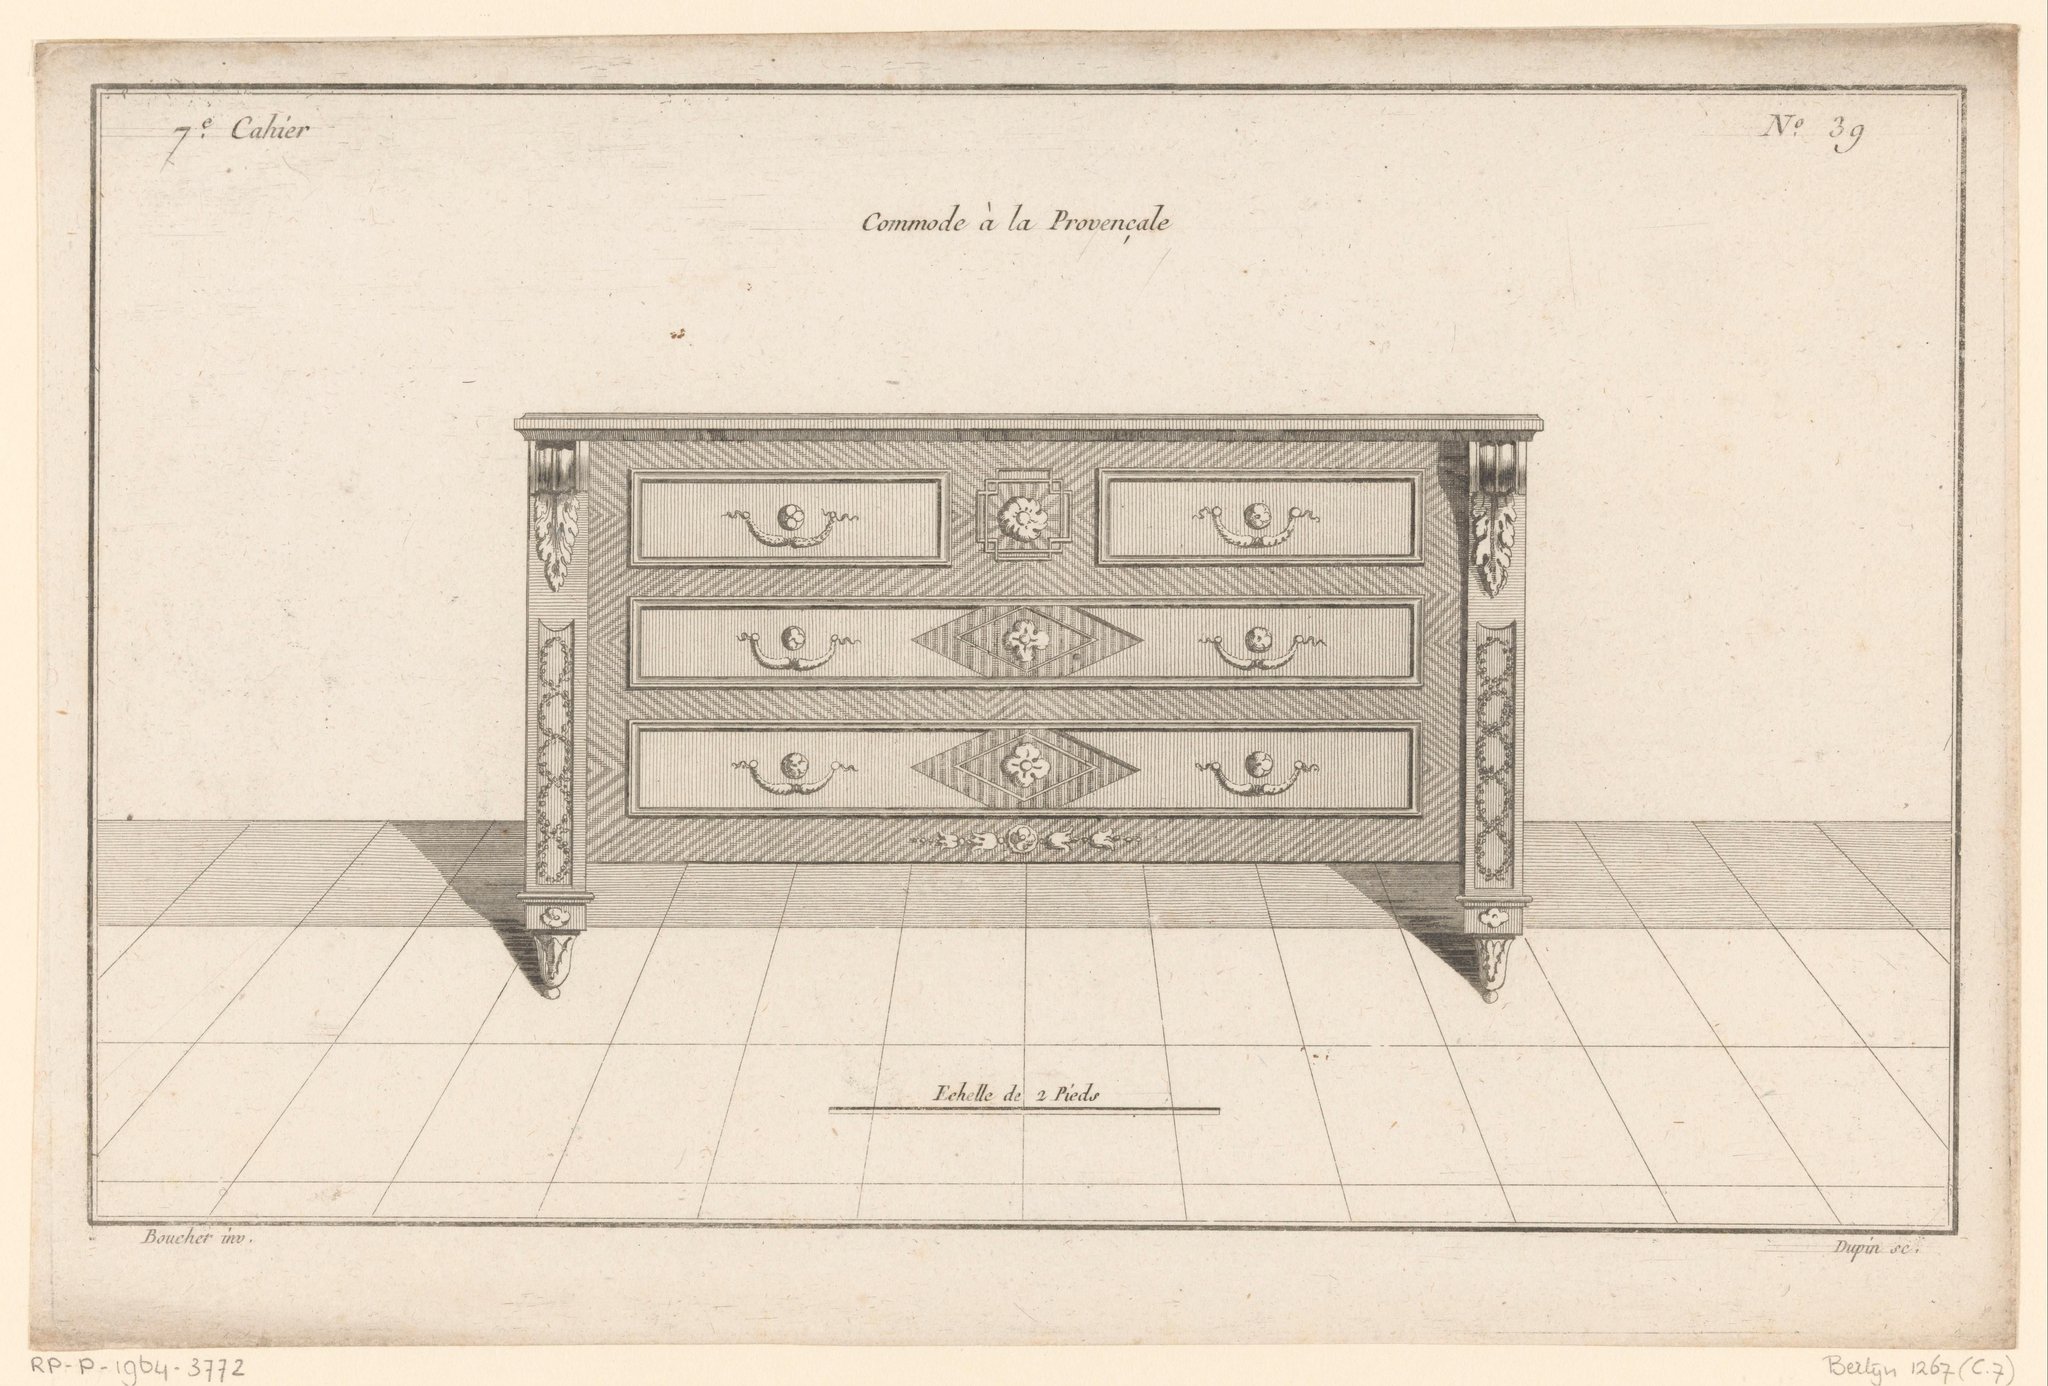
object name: print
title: Commode met blad- en bloemmotieven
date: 1772-1779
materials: paper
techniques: engraving, etching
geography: paris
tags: ornamental cupboard, ornament derived from plant forms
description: Een geornamenteerde commode met vier lades, met blad-en bloemmotieven. Prentnummer 39.